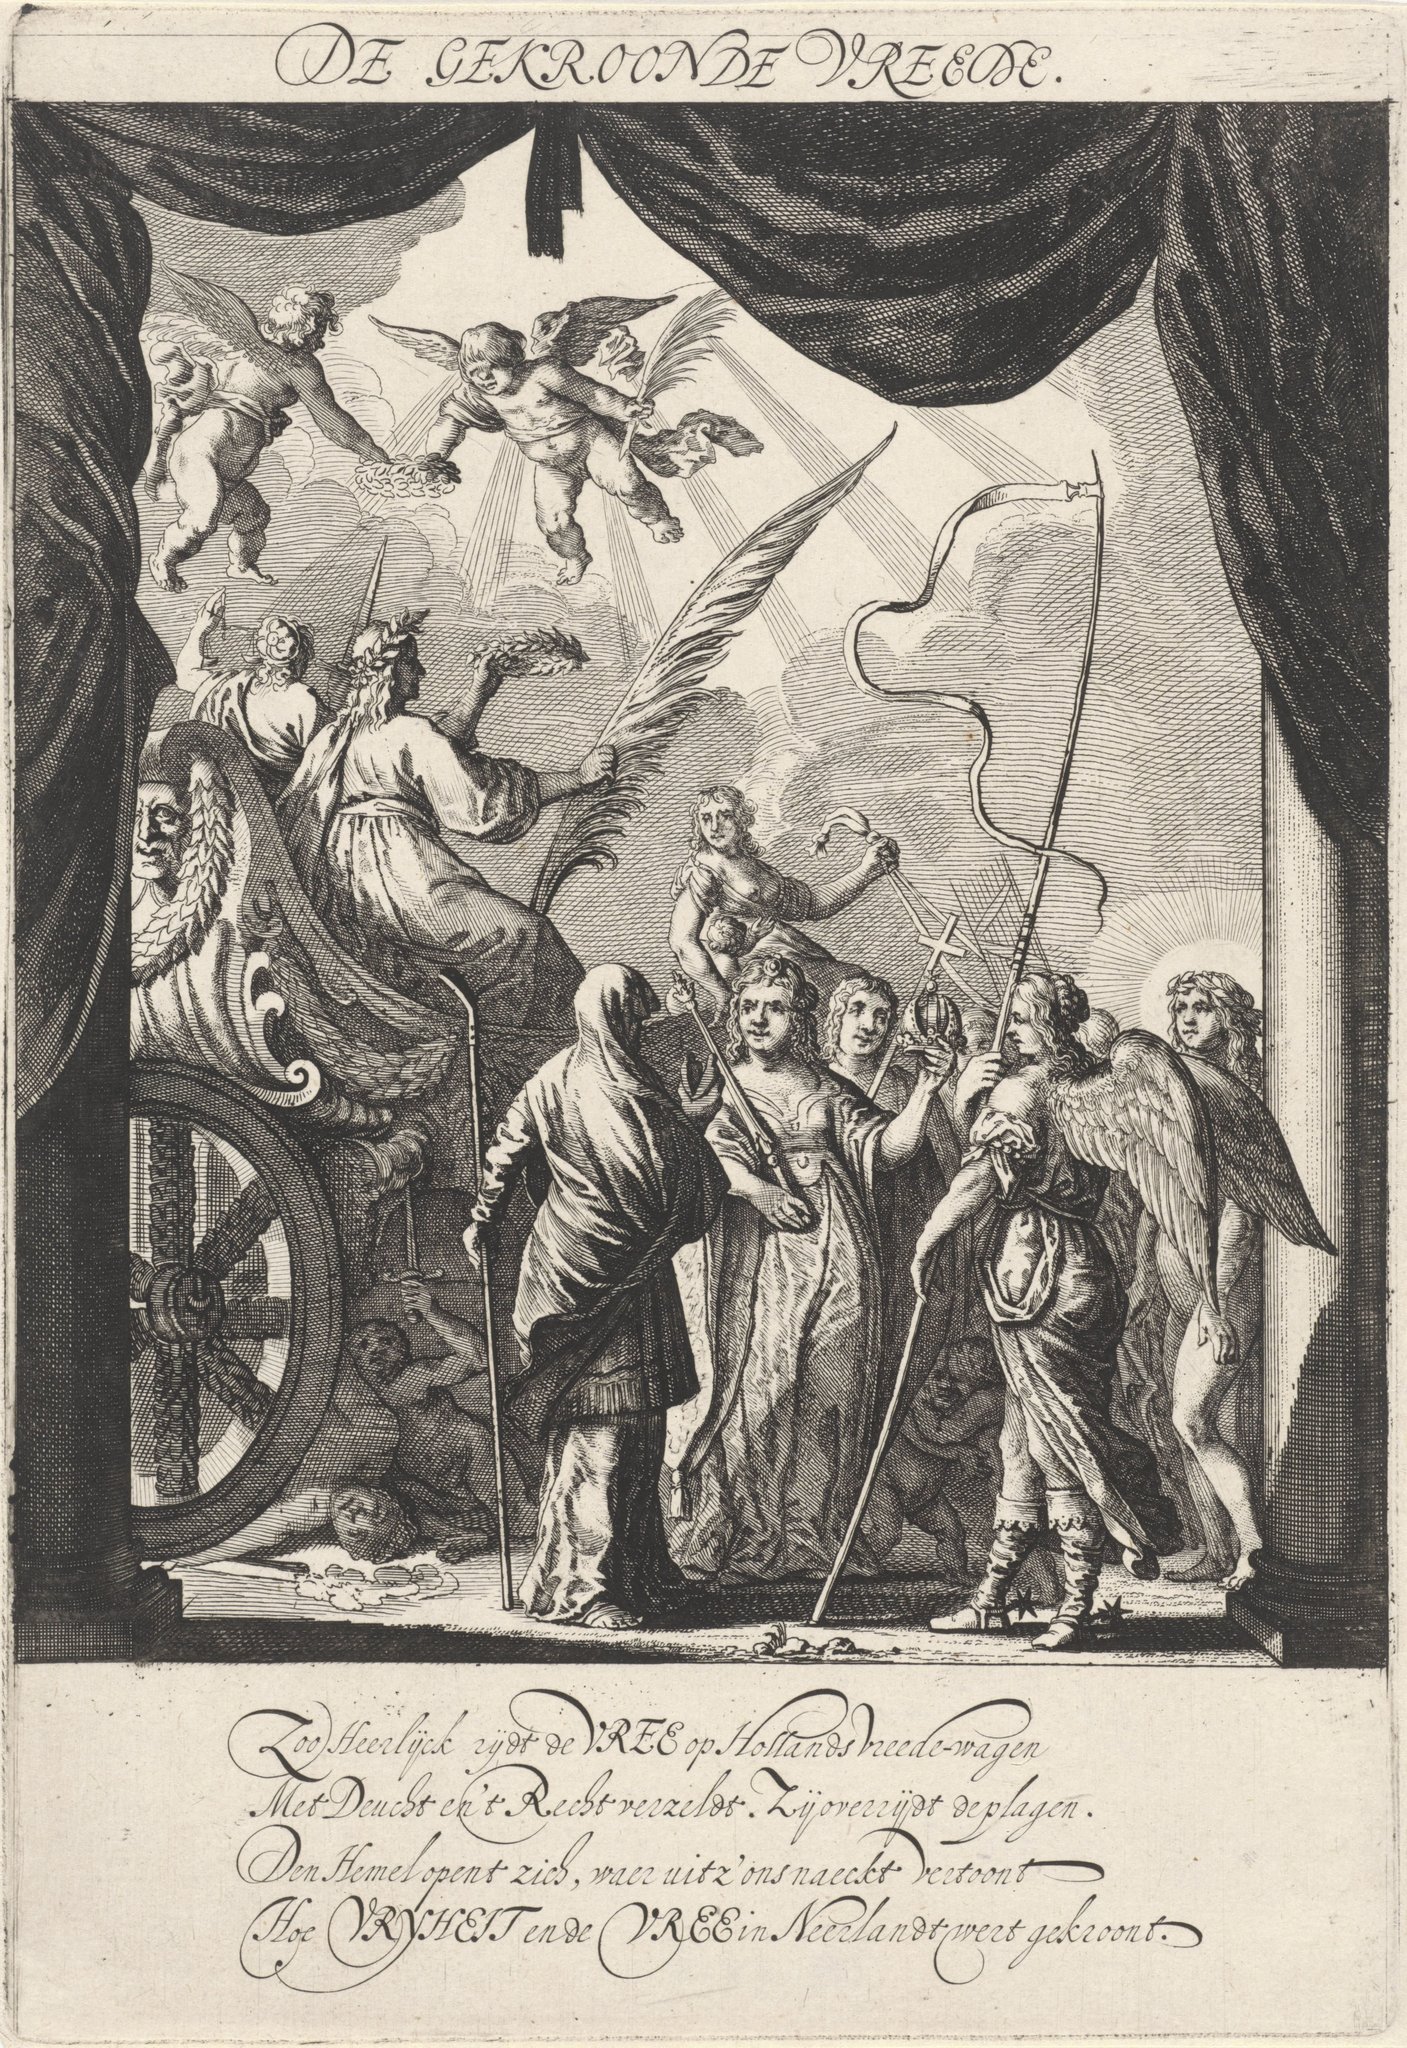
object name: print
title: Vertoning van de Gekroonde Vrede, 1648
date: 1649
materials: paper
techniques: etching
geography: amsterdam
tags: symbols, allegories of peace, 'pax'; 'pace' (ripa), theatre, theatrical performance, festivities on events of national importance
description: Vertoning van de Gekroonde Vrede. Onderdeel van de vertoningen opgevoerd op 23 juni 1648 op de Schouwburg te Amsterdam naar aanleiding van het sluiten van de Vrede van Munster. De eerste voorstelling toont de aankomst van de triomfwagen van de Vrede met de Rechtvaardigheid en de kroning van de Vrede door twee putti. In het onderschrift een vers van 4 regels in het Nederlands.